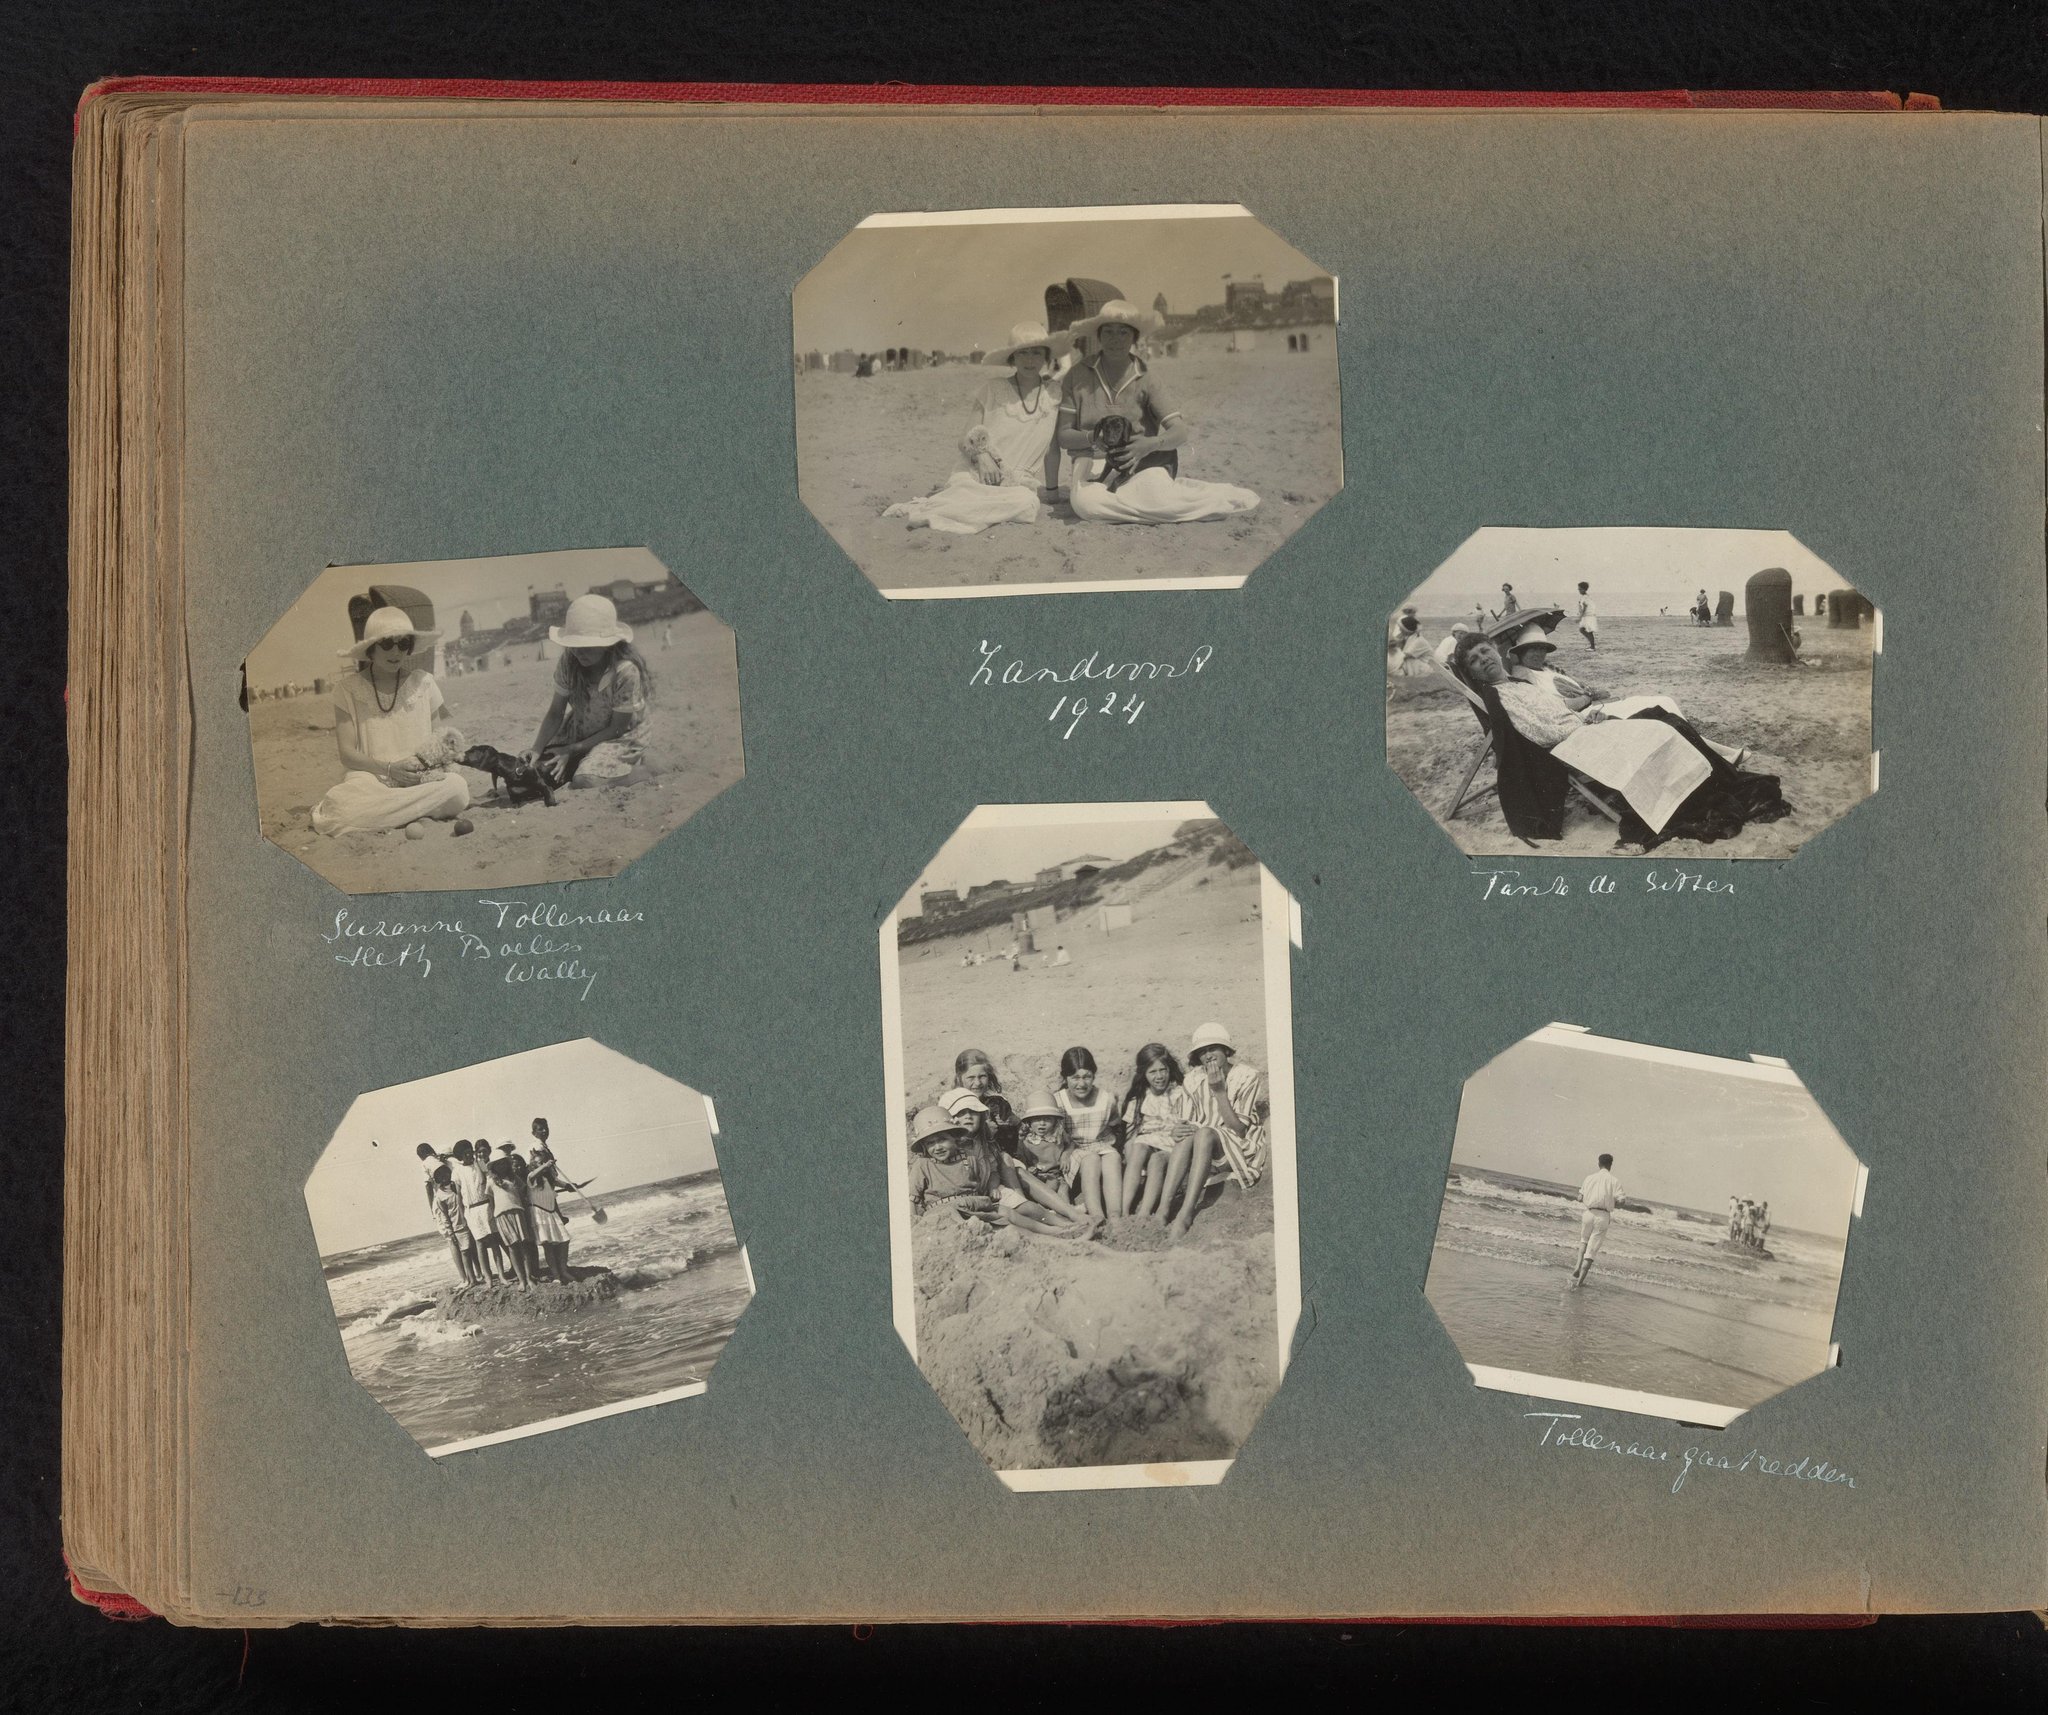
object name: album leaf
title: Hetty Boelen op het strand van Zandvoort met de familie Tollenaar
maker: charlotte alida boelen-matthes (lot)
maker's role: amateurfotograaf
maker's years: 1889-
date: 1924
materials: paper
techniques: gelatin silver print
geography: zandvoort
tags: beach (as place of recreation)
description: Deze foto's zijn onderdeel van een album.